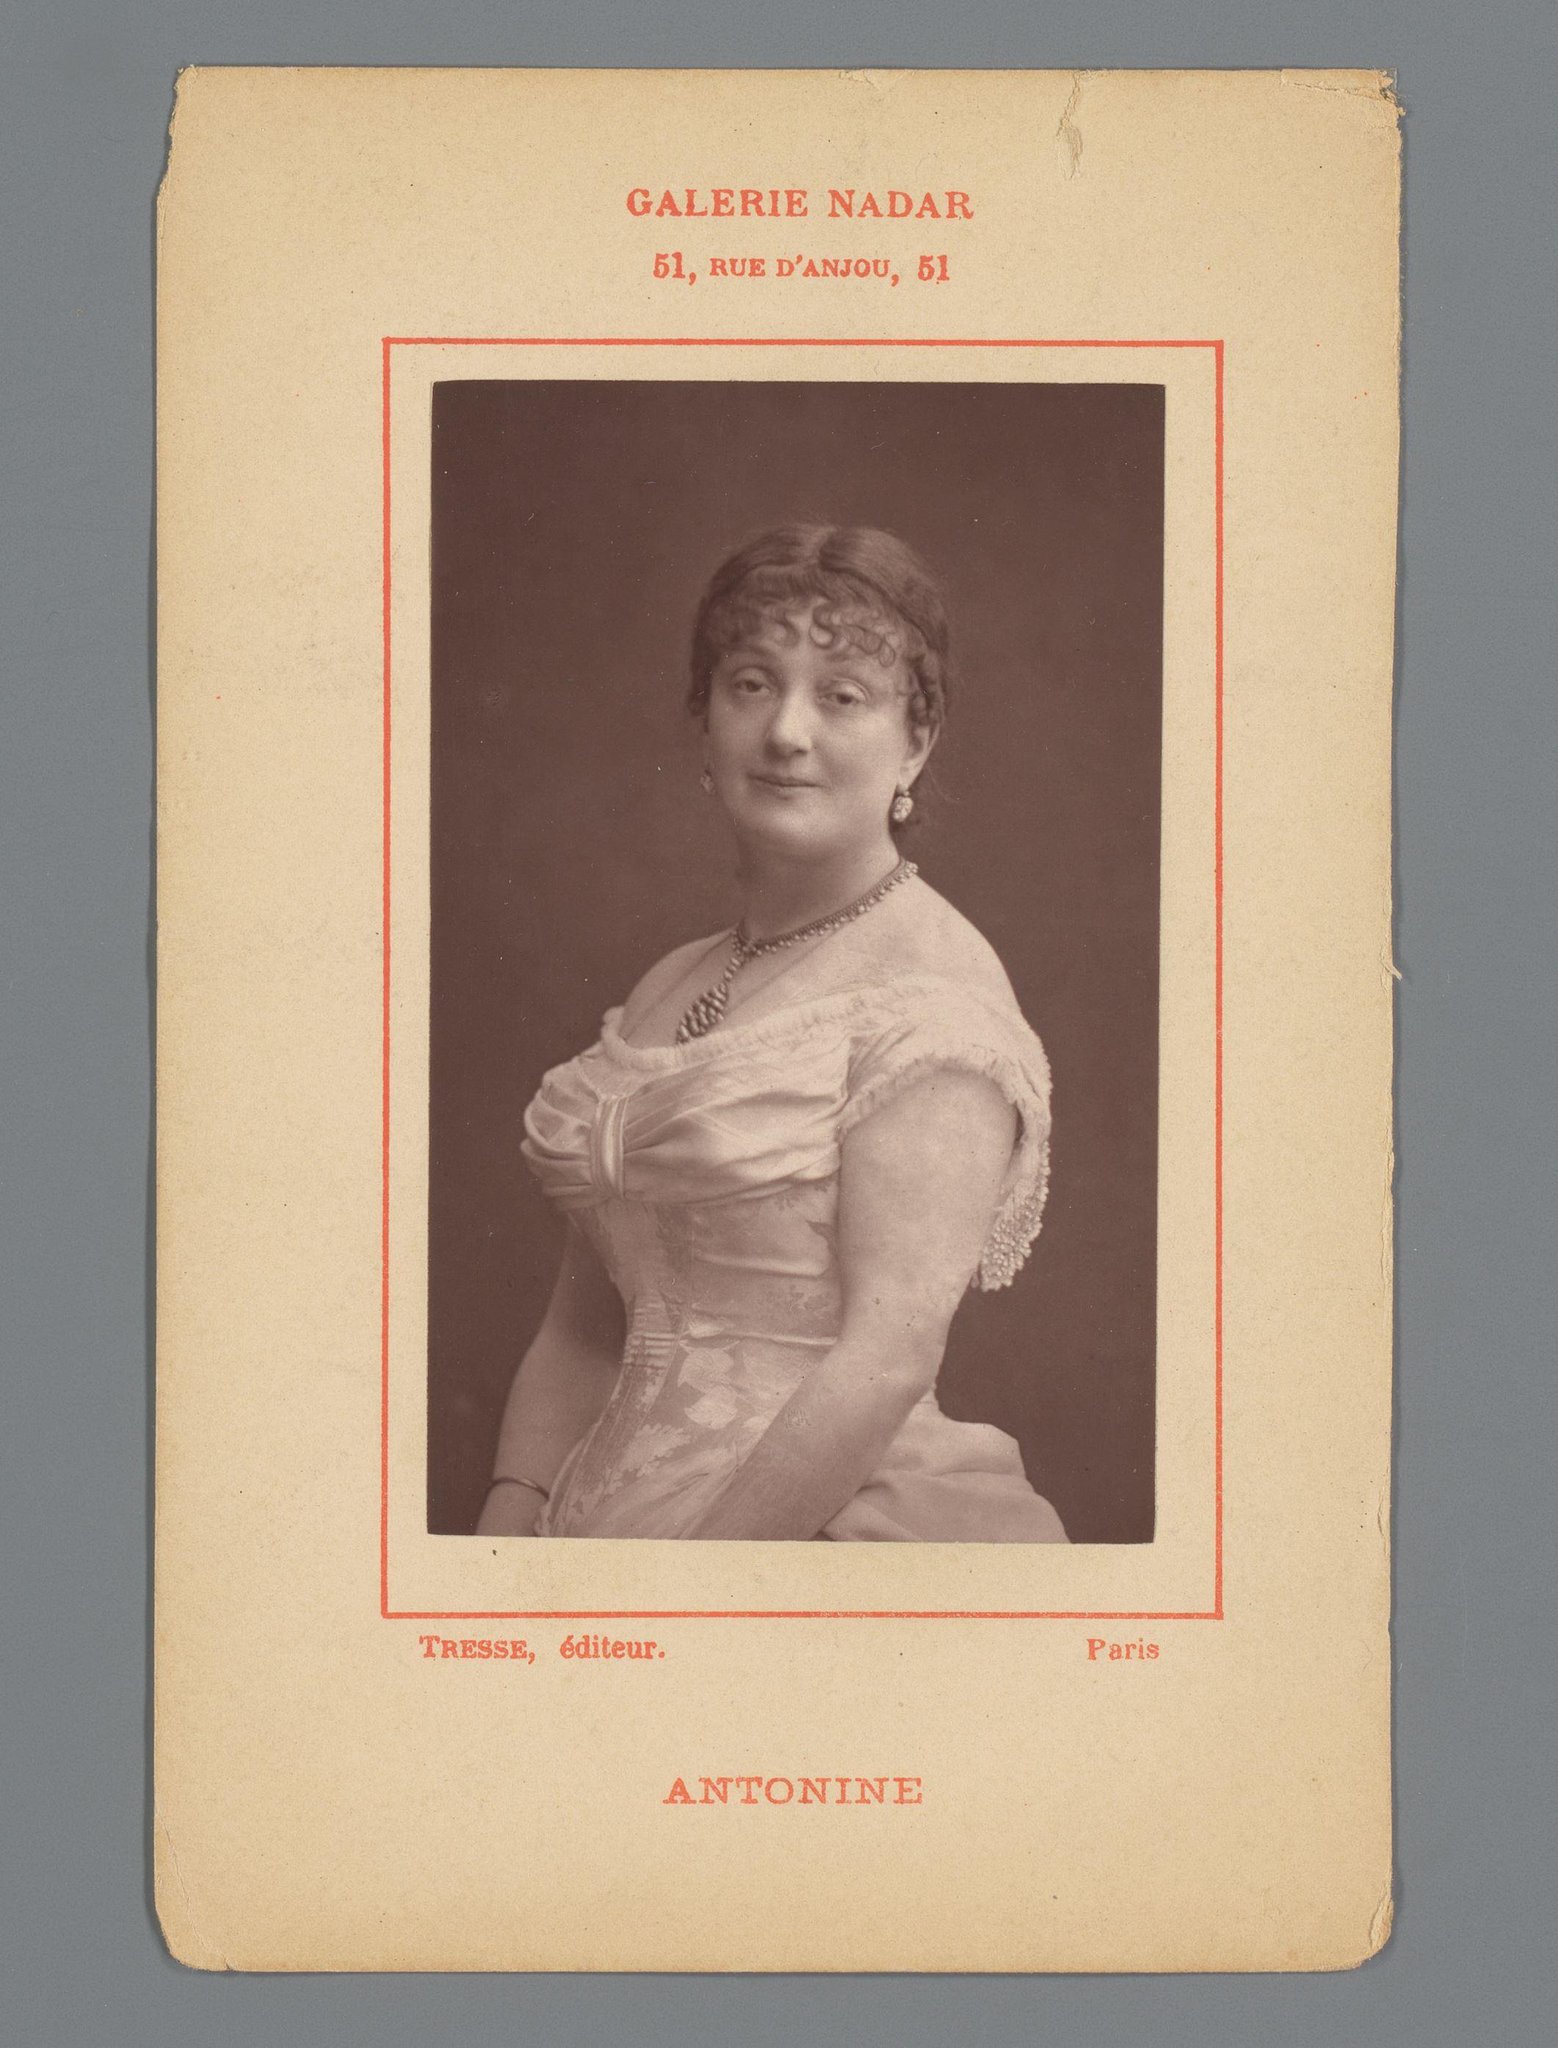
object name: cabinet photograph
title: Portret van Antonine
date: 1873-1910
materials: paper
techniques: albumen print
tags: portrait of actor, actress, france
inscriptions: address: ‘GALERIE NADAR/ 51, RUE D'ANJOU, 51/ TRESSE, éditeur./ Paris’